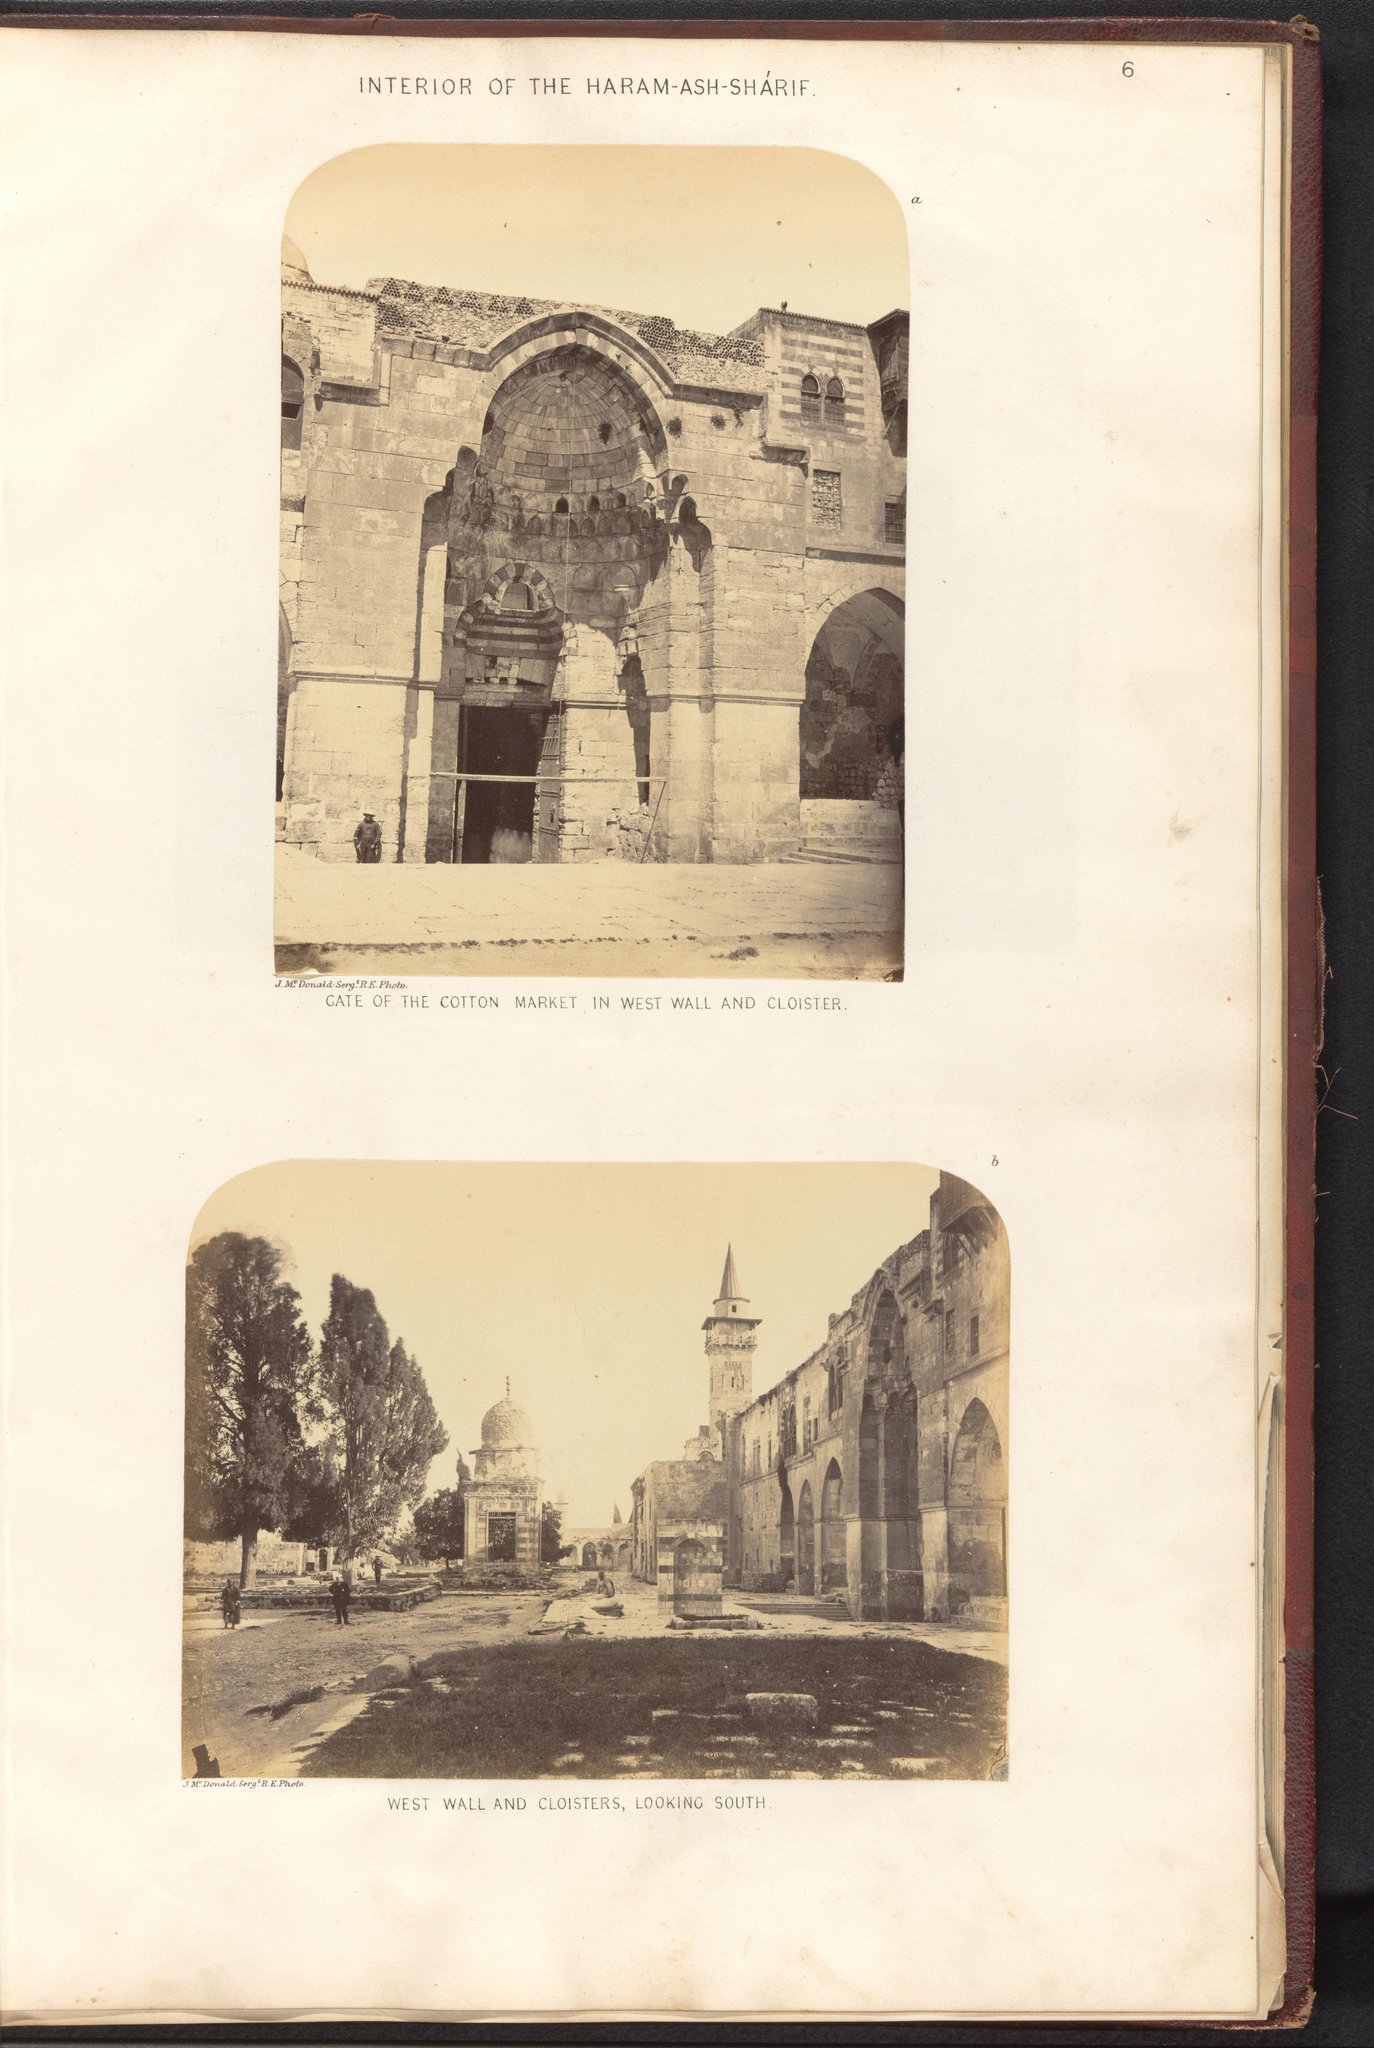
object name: photograph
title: Gezicht op de ingang van de Katoenmarkt en een gezicht op de westelijke muur en het klooster, op de Tempelberg in Jeruzalem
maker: james mcdonald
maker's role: fotograaf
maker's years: 1822-1885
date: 1860-1865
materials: paper, photographic support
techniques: albumen print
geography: tempelberg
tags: wailing wall ~ jewish religion, cloisters ~ monastery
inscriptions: inscription: ‘a’, inscription: ‘b’